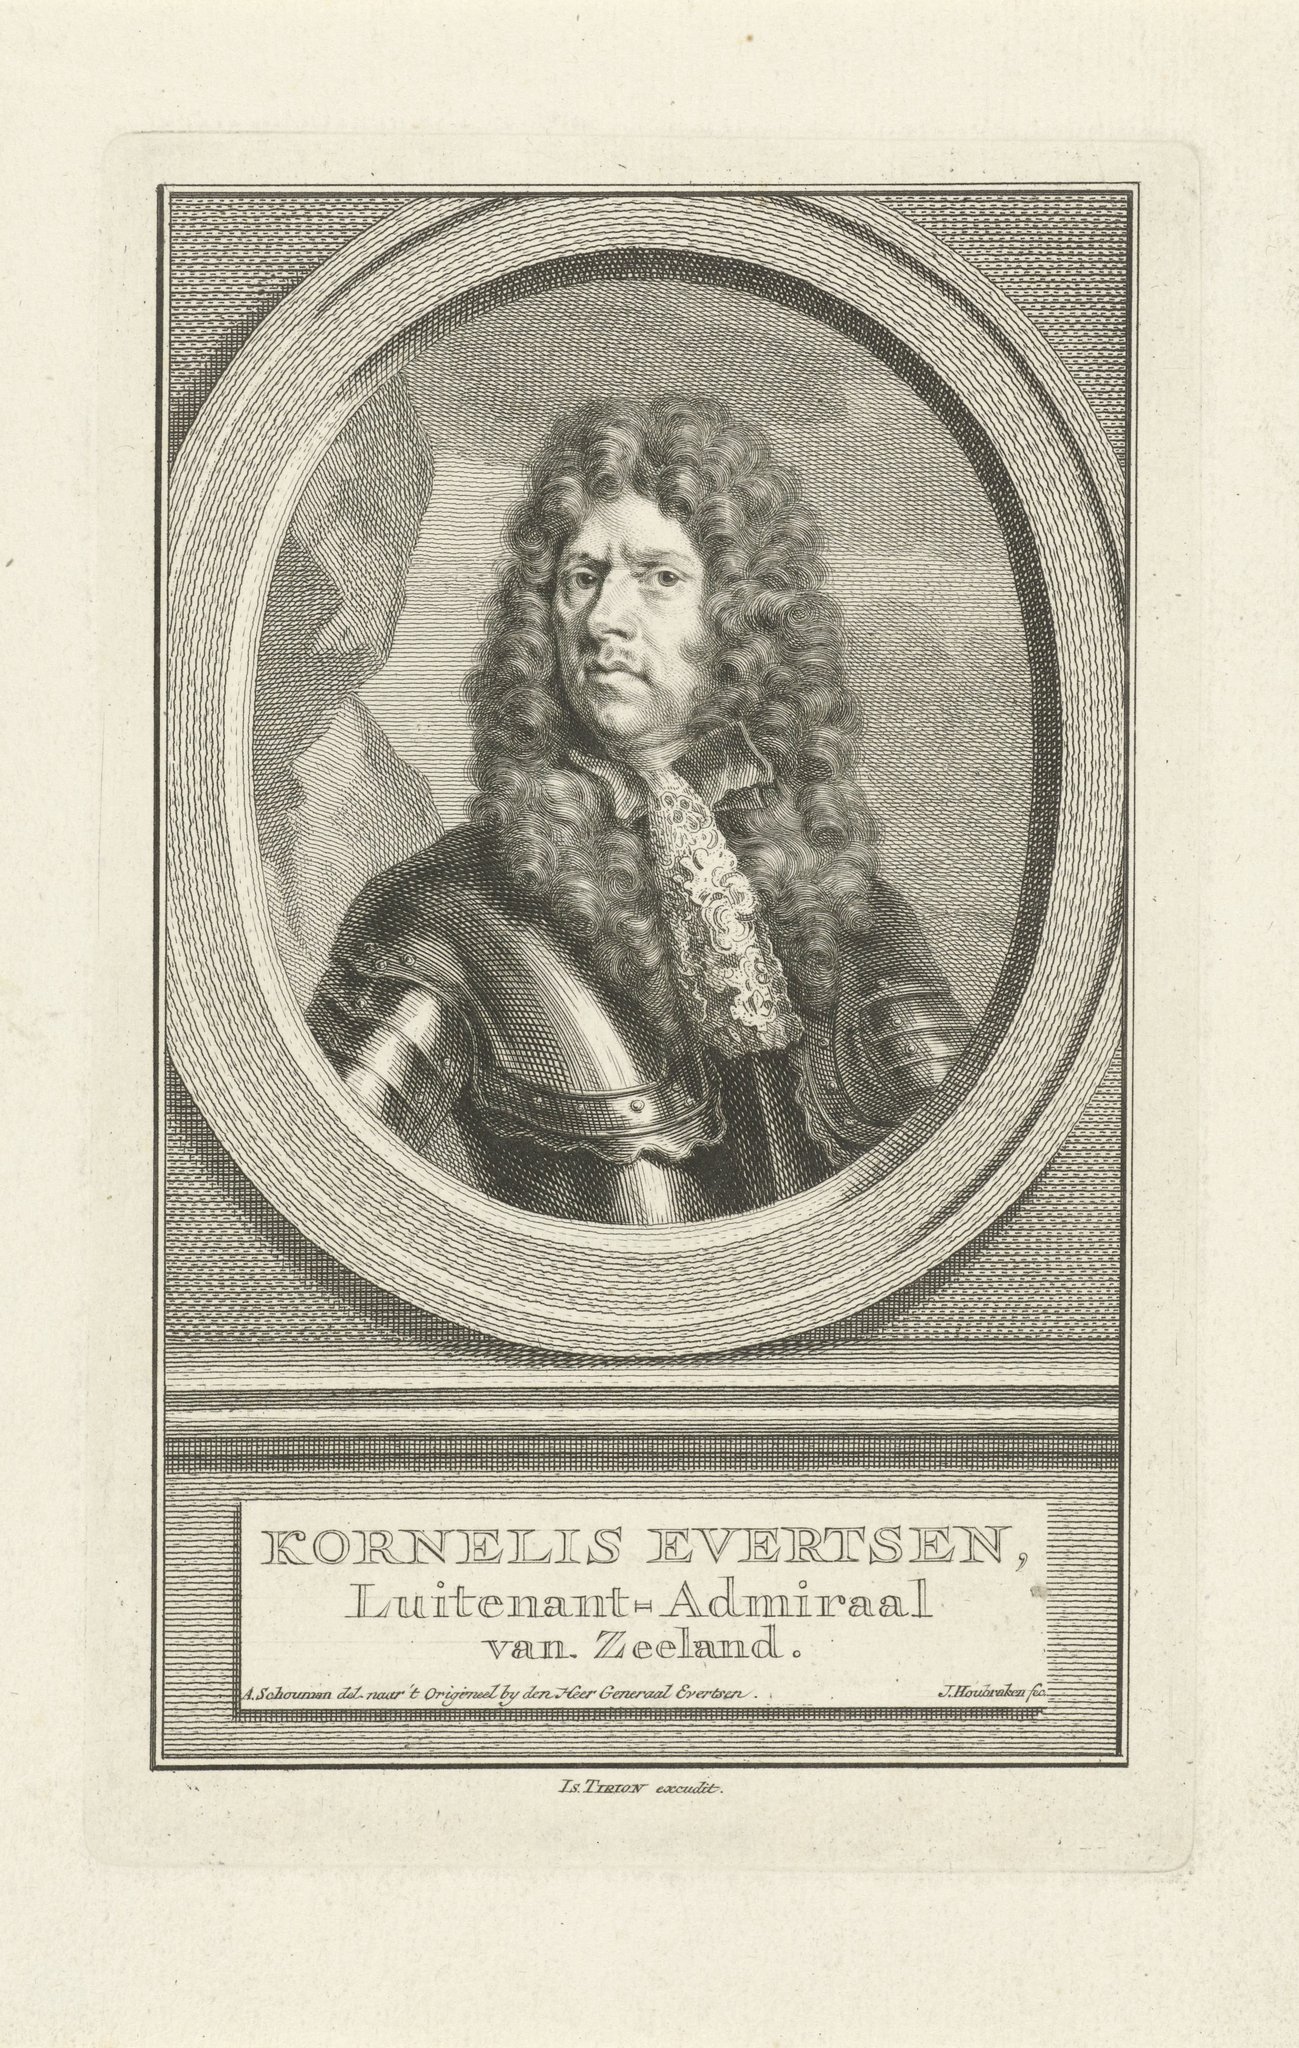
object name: print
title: Kornelis Evertsen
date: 1749-1759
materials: paper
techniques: engraving, etching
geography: amsterdam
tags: flushing, middelburg, cornelis evertsen (ii)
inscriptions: collector's mark: Lugt 2228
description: Prent ook gebruikt in: Jan Wagenaar, Vaderlandsche historie, vervattende de geschiedenissen der nu Vereenigde Nederlanden, inzonderheid die van Holland (...), 21 delen. Amsterdam, Isaak Tirion, 1749-59. Prent volgens Ver Huell ook gebruikt in: Portraiten van eenige der vermaardste staatsmannen en zeehelden, als toevoeging op: Willem Tiberius Hattinga, Atlas van Zeeland. Amsterdam: Isaak Tirion, 1760.